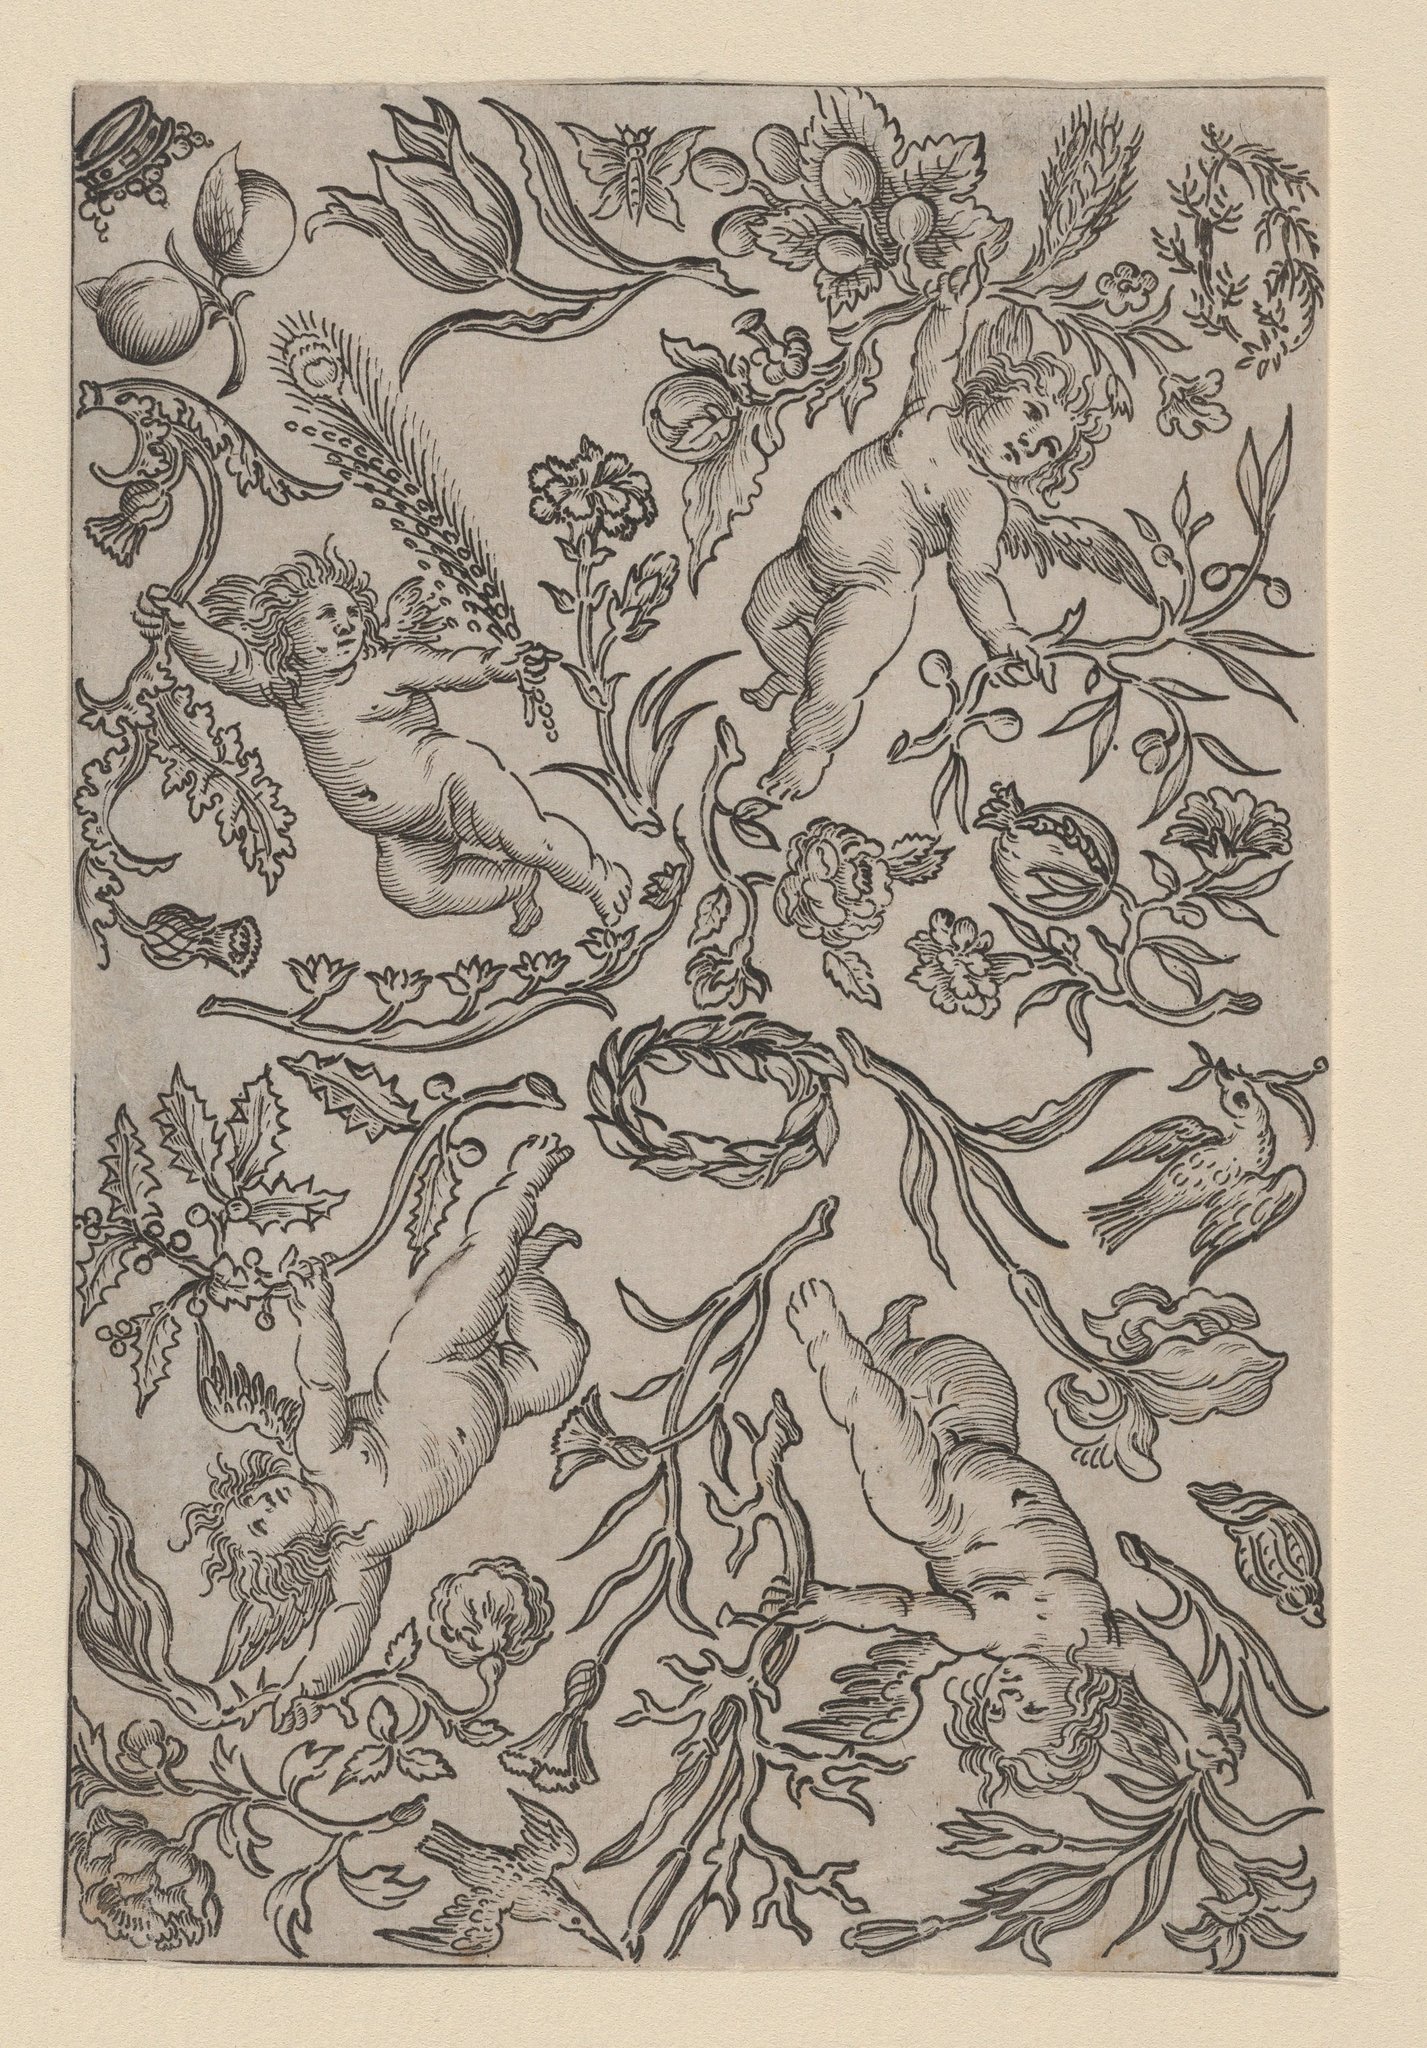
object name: print ornament architecture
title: Design for a Gilt Leather Panel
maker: anonymous, dutch, 17th century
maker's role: artist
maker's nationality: dutch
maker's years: 1600-1700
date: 1660-1670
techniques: engraving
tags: fruit,flowers,wreaths